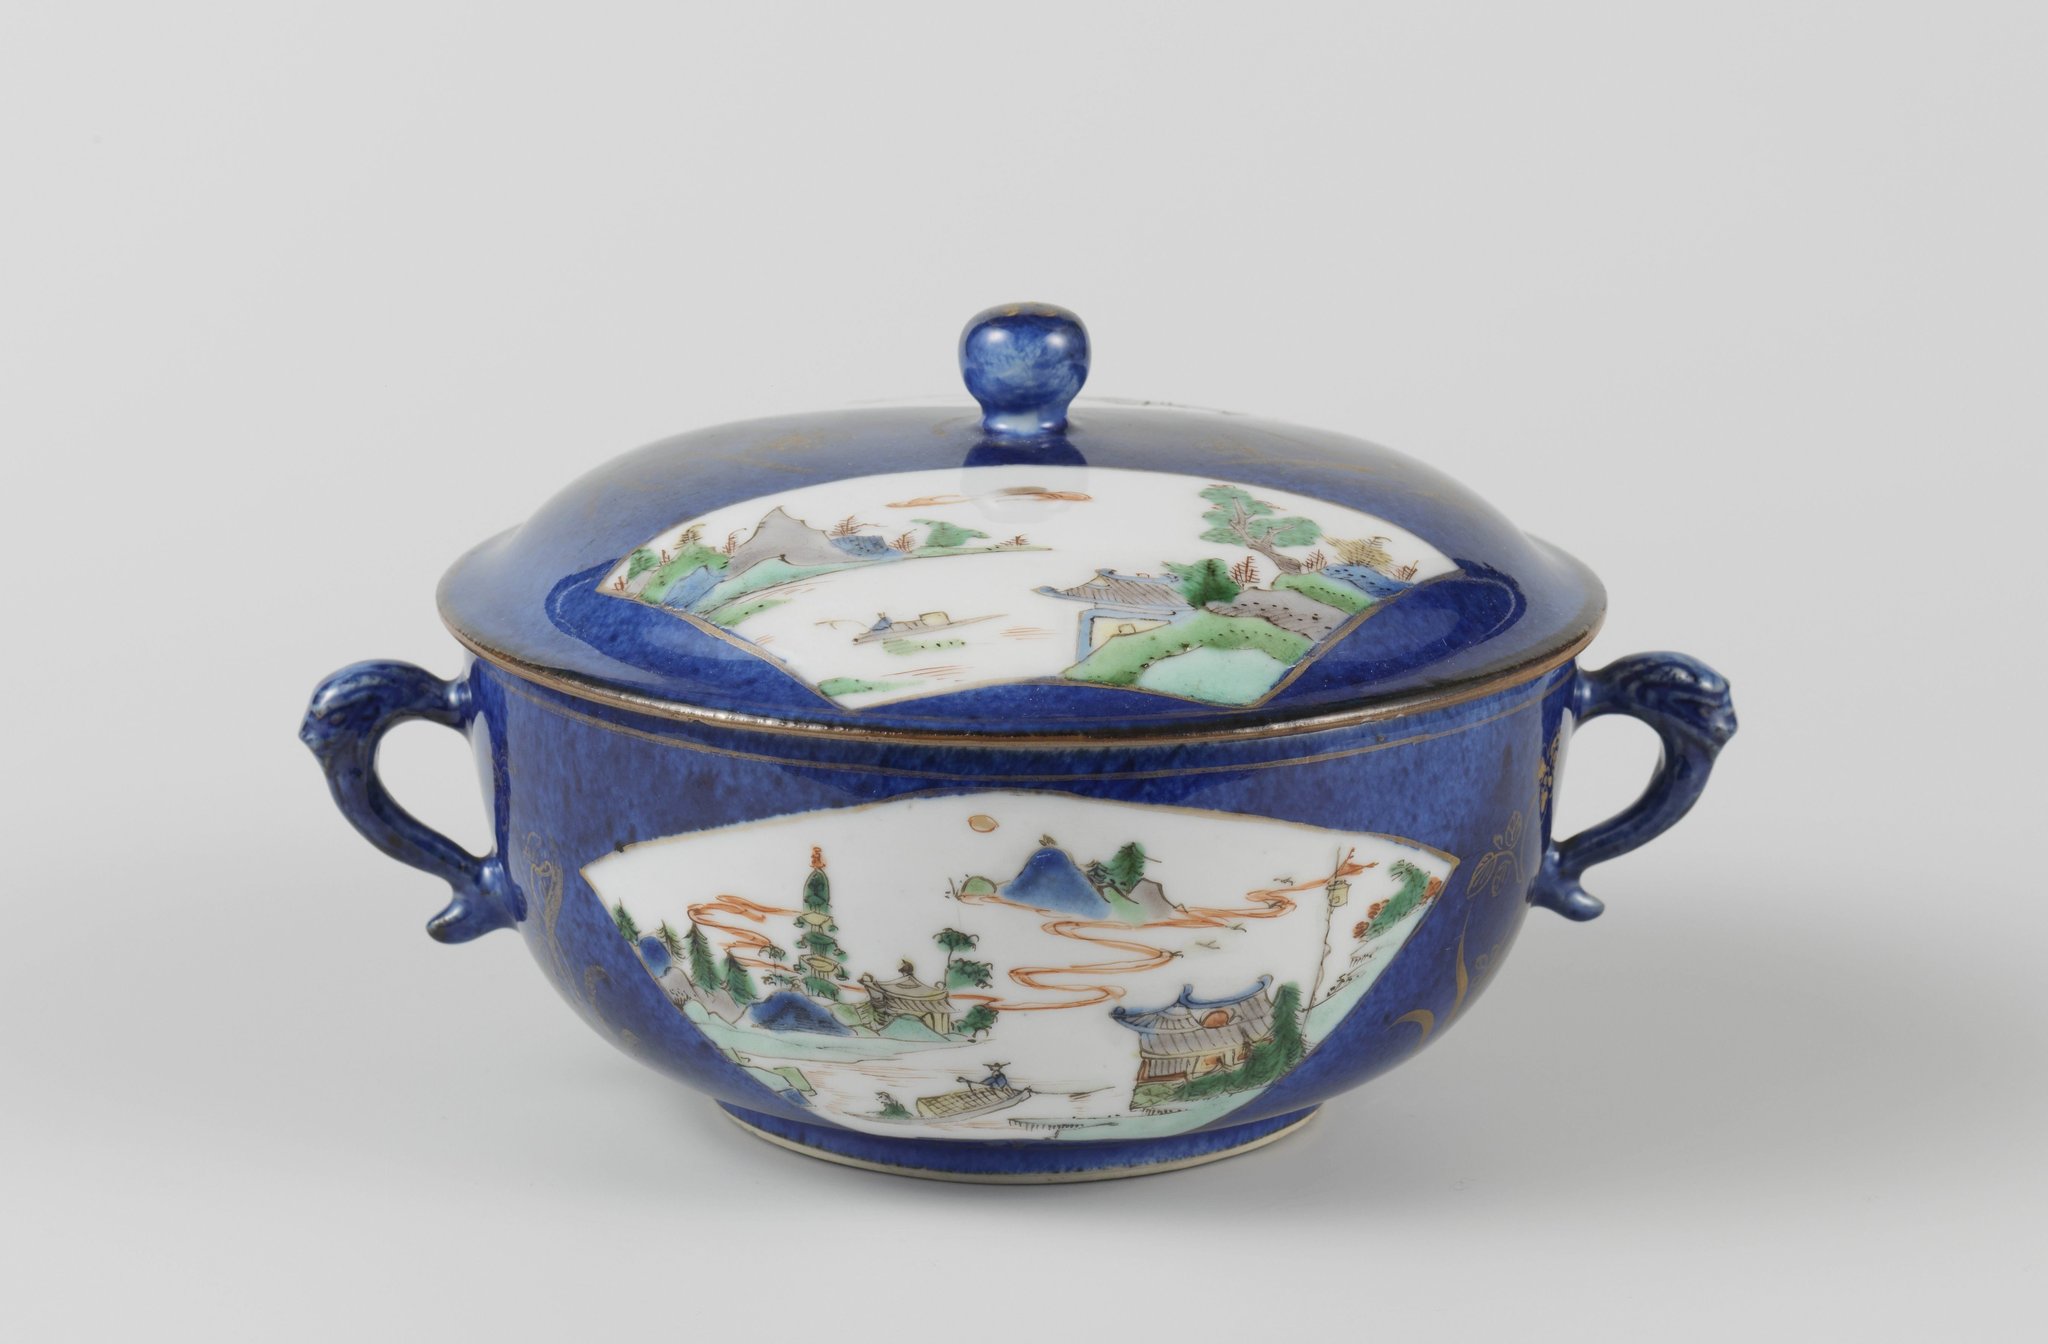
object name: covered bowl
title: Covered bowl with powder blue and river landscapes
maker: Anonymous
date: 1700-1720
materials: cobalt, glaze, gold, paint, porcelain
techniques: firing, gilding, turning, vitrification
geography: china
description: Deksel met knop van kom van porselein, beschilderd in onderglazuur blauw en op het glazuur blauw, rood, groen, geel, aubergine, zwart en goud. Bedekt met bleu poudré (poederblauw), met hierin uitgespaard twee waaiervormige vakken met een rivierlandschap gevuld met personen, paviljoens en bomen; naast de vakken een bloemtak in goud. Drie chips in de rand van de deksel. Bleu poudré met famille verte.